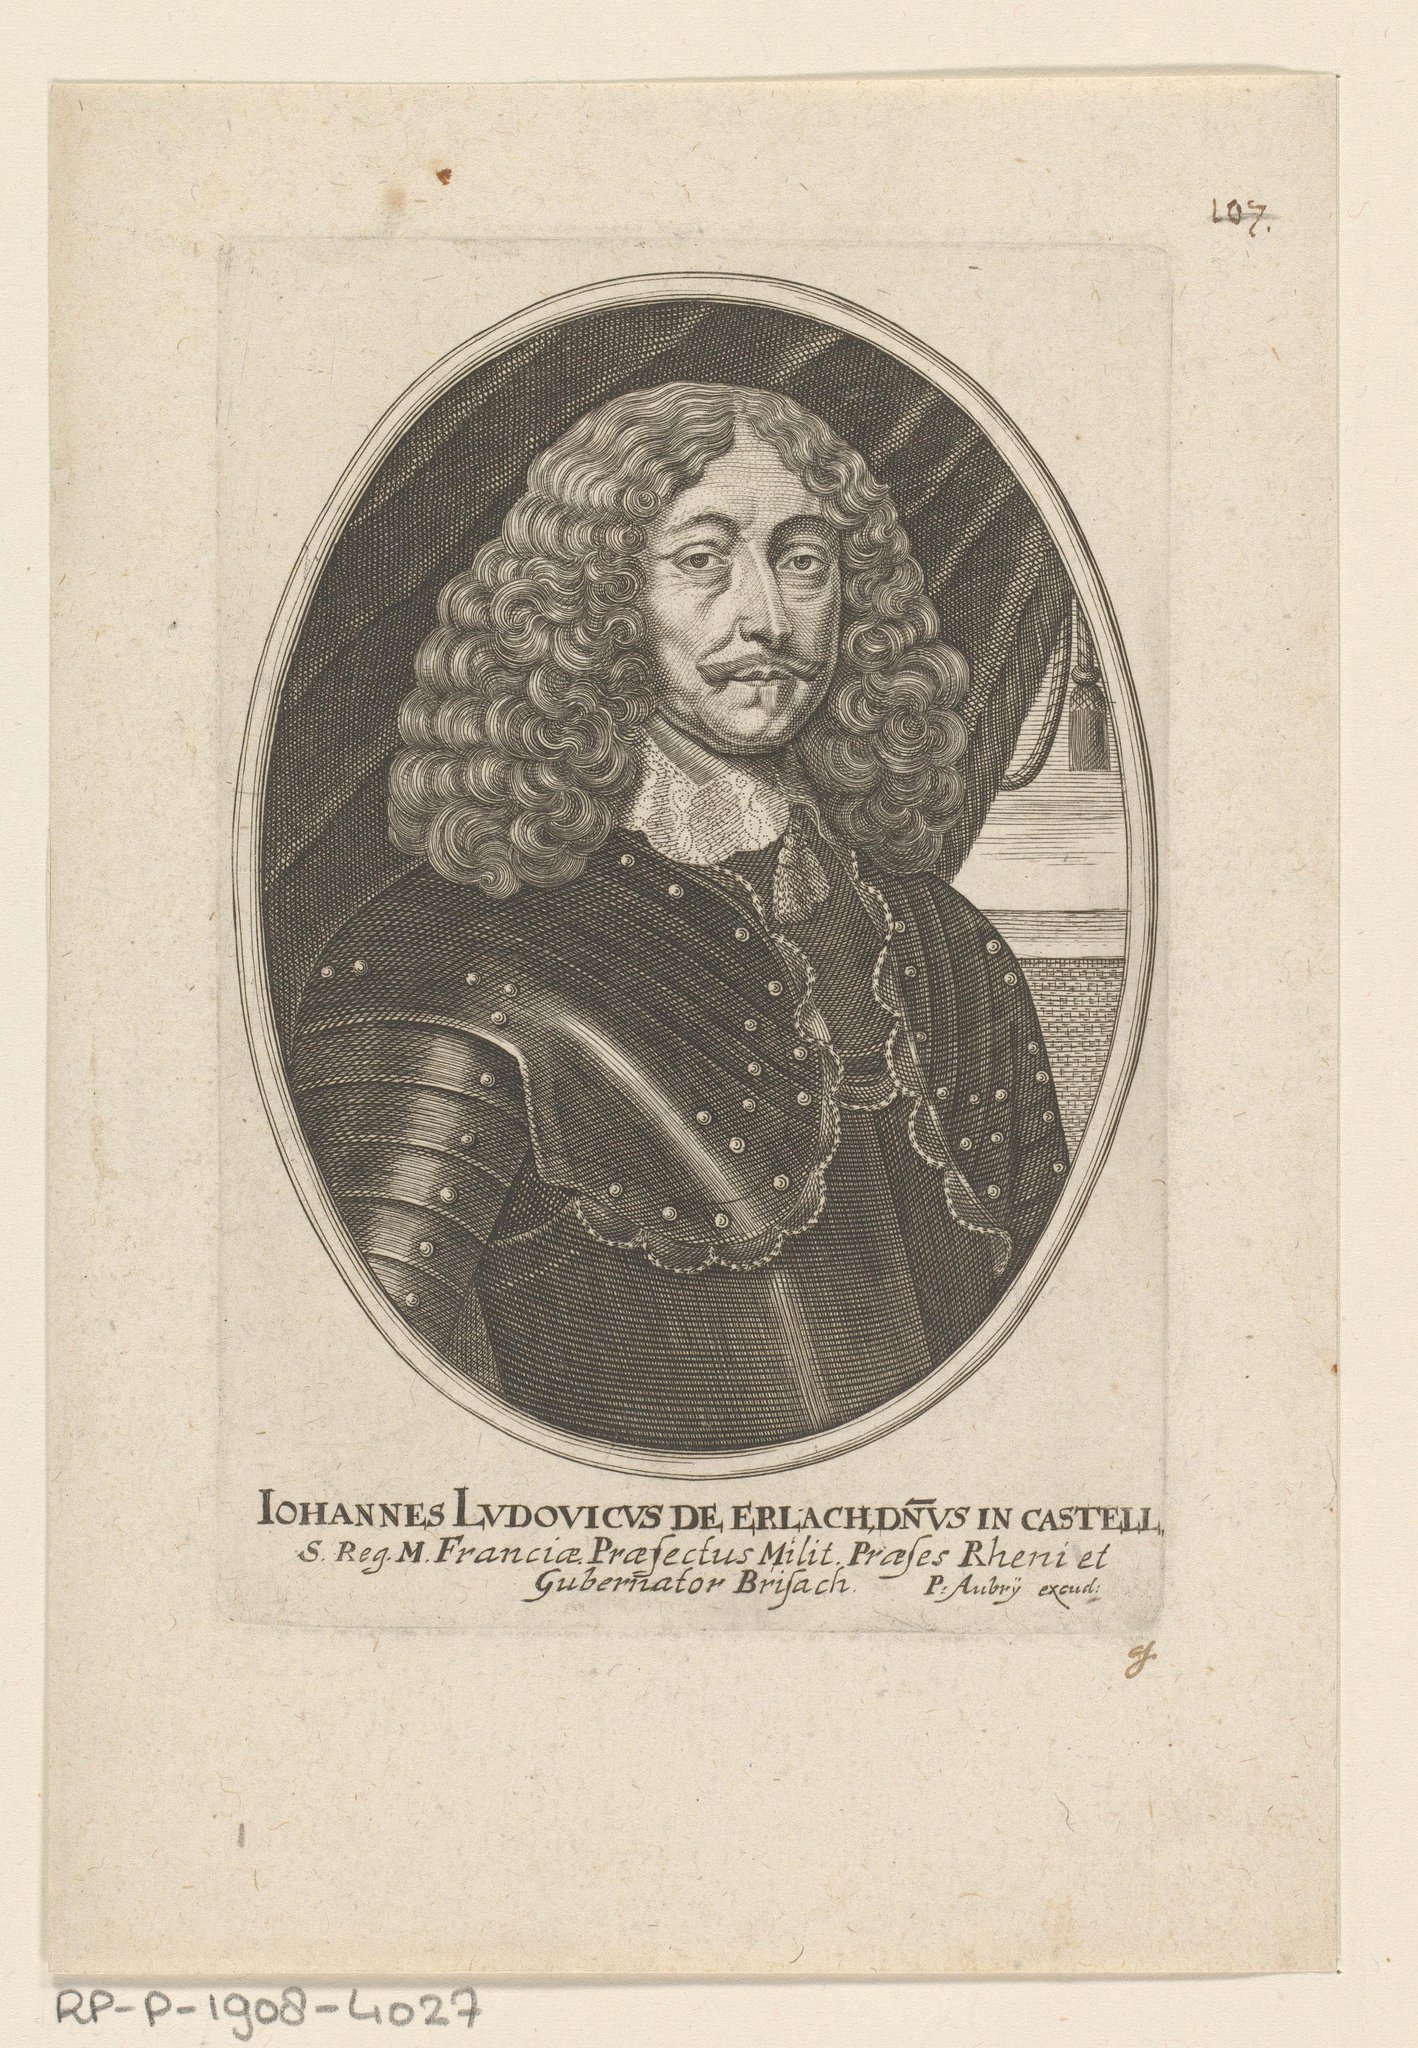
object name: print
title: Portret van Johann Ludwig von Erlach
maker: Anonymous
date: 1635-1686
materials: paper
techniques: engraving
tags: jean louis d' erlach, historical persons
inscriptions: collector's mark: Lugt 2228, inscription: ‘g’, number: ‘107’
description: Met drieregelig onderschrift in het Latijn.